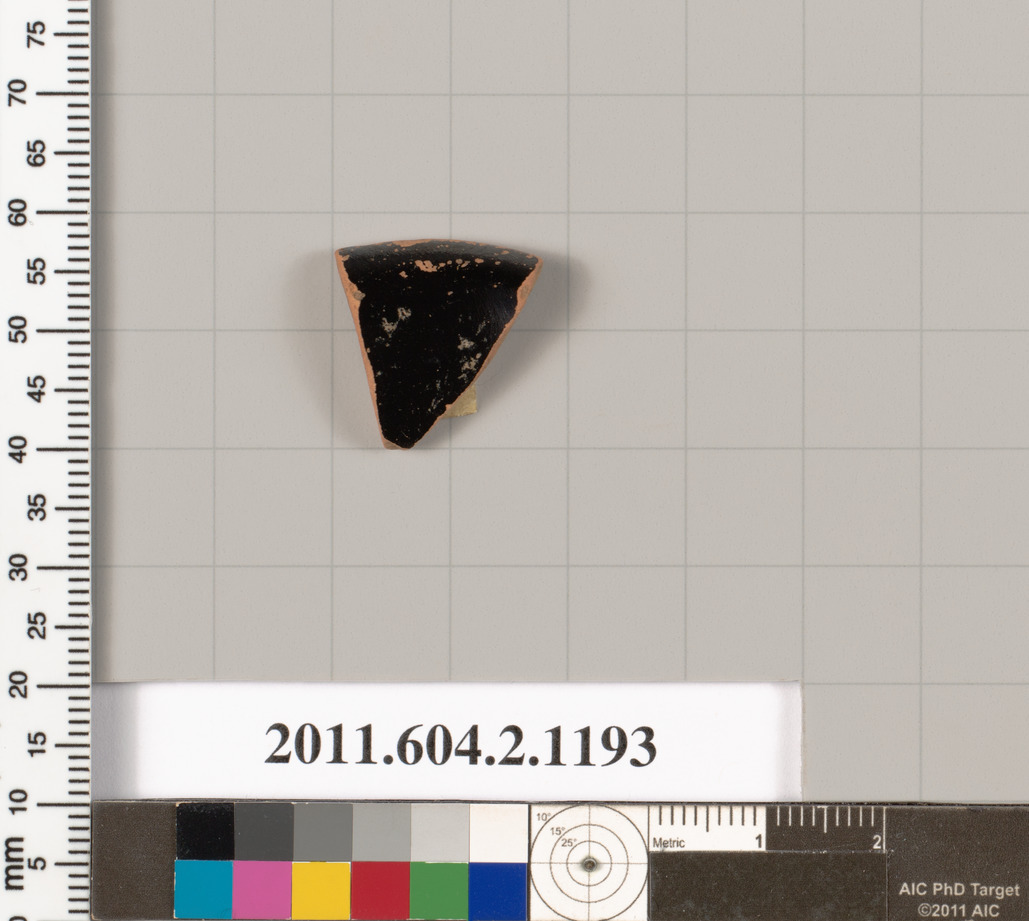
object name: oinochoe fragment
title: Terracotta fragment of an oinochoe (jug)?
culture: greek, attic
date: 500-401 BCE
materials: terracotta